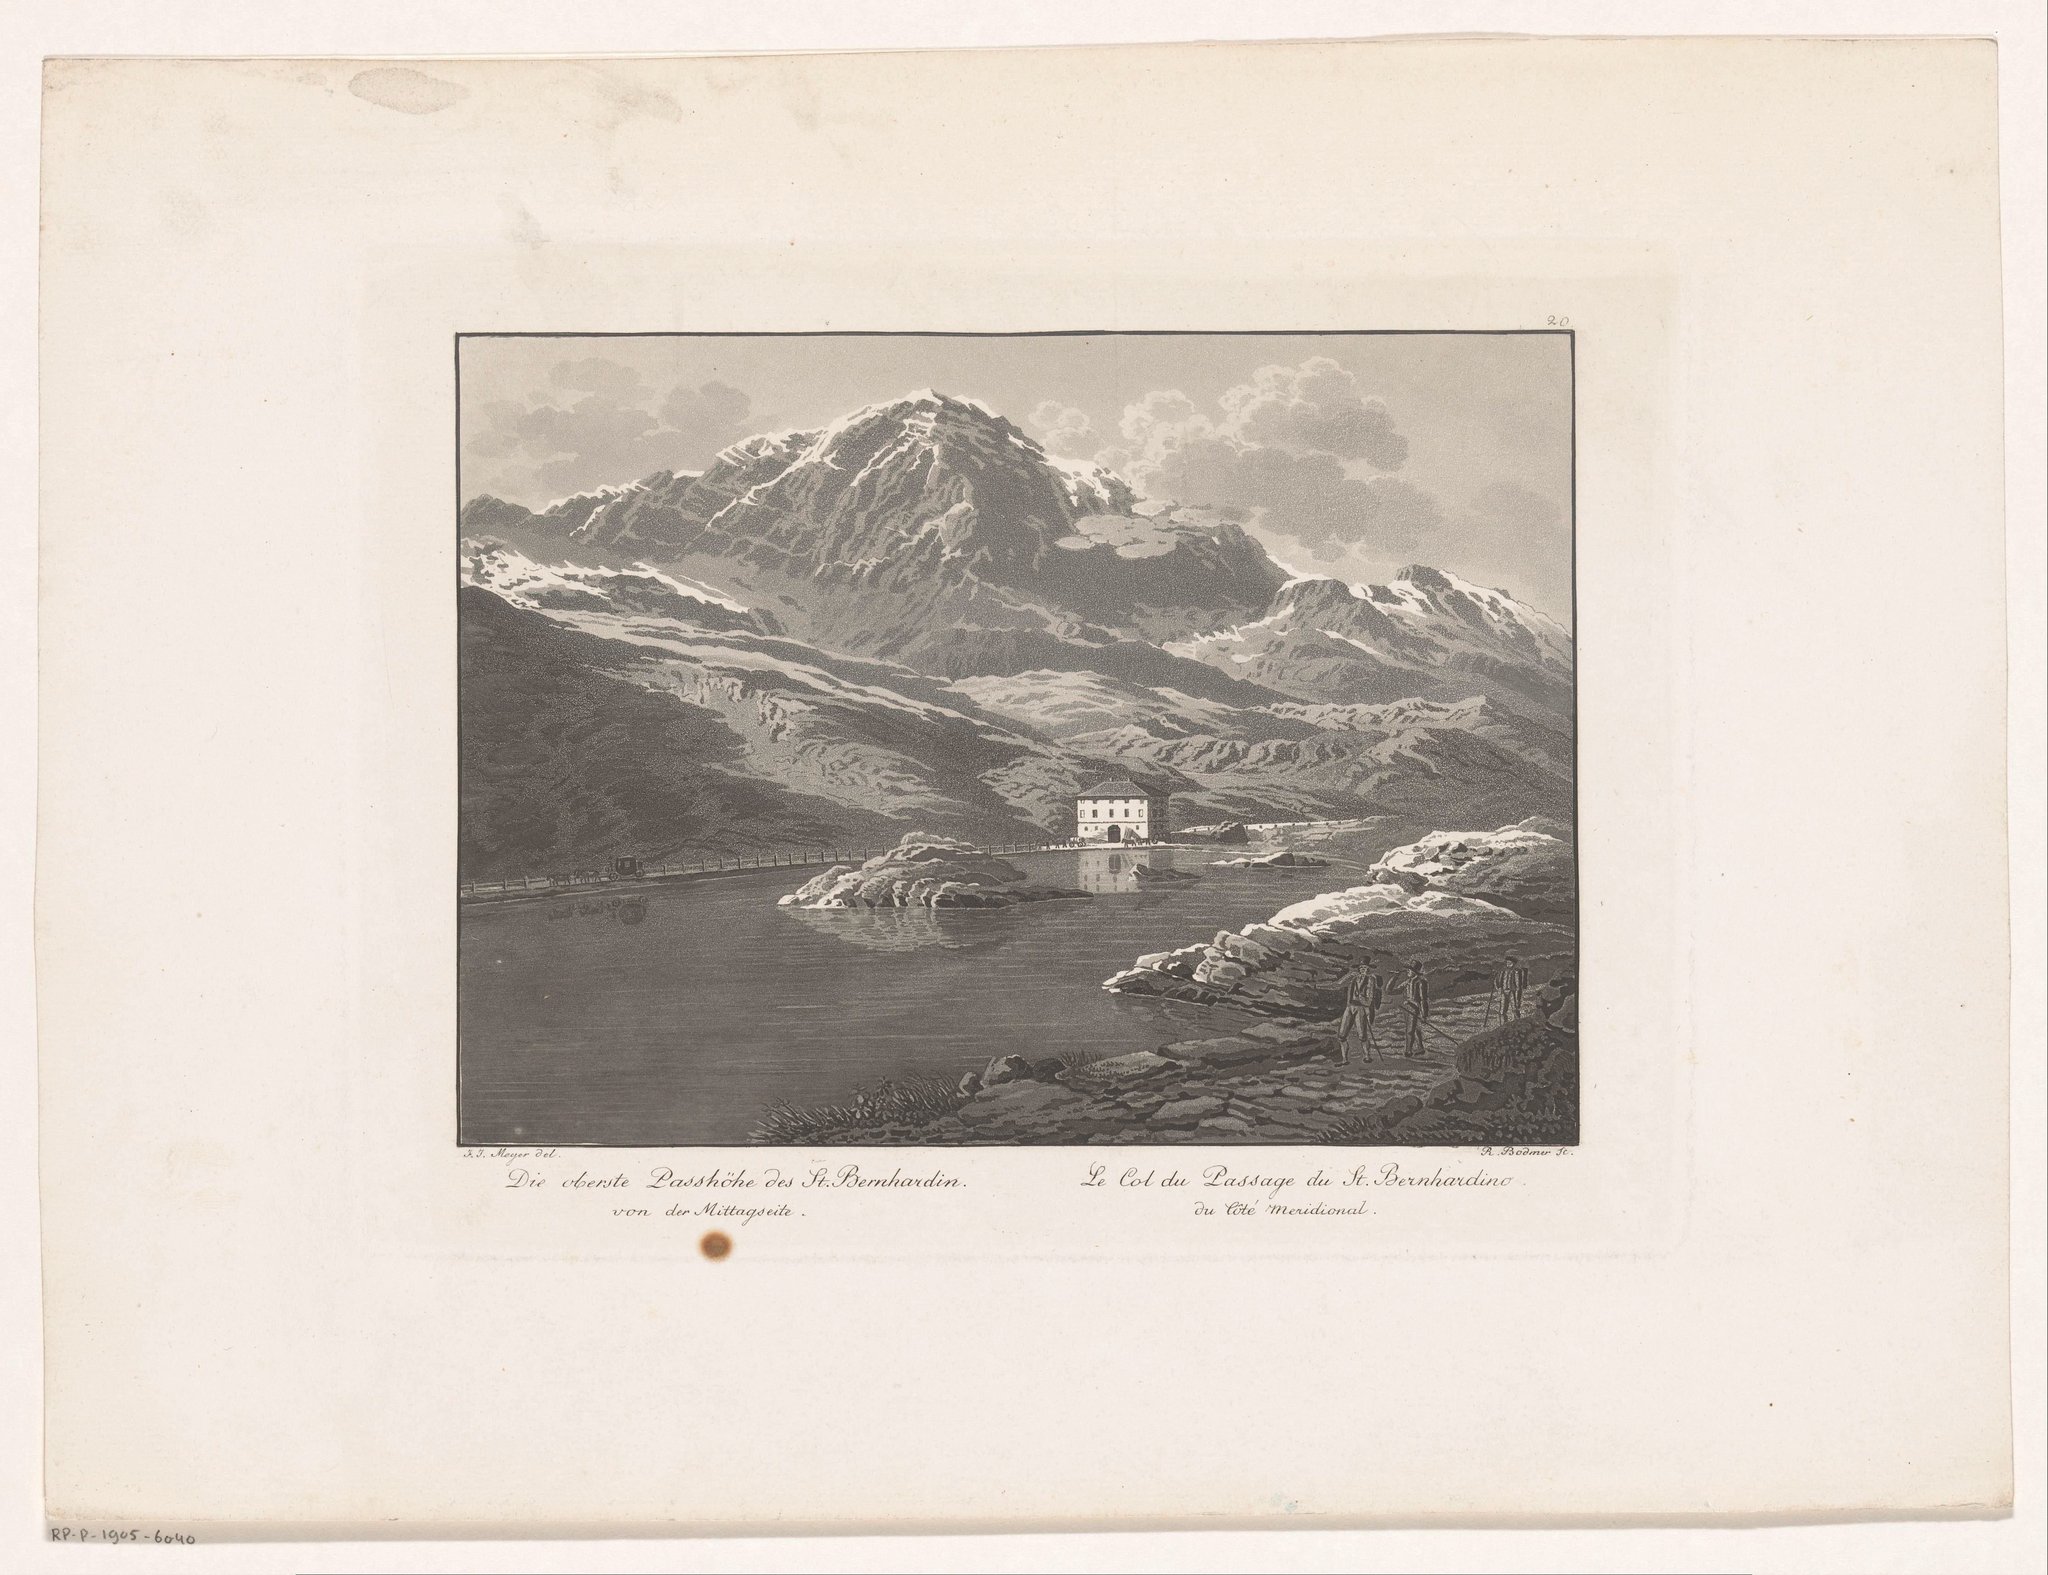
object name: print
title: Naaiende vrouw aan een tafel, aan de muur een vogelkooi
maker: johann wilhelm baumann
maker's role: print maker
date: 1825-1900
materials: paper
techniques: engraving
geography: munich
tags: needle ~ sewing, bird in a cage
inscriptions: collector's mark: Lugt 2228